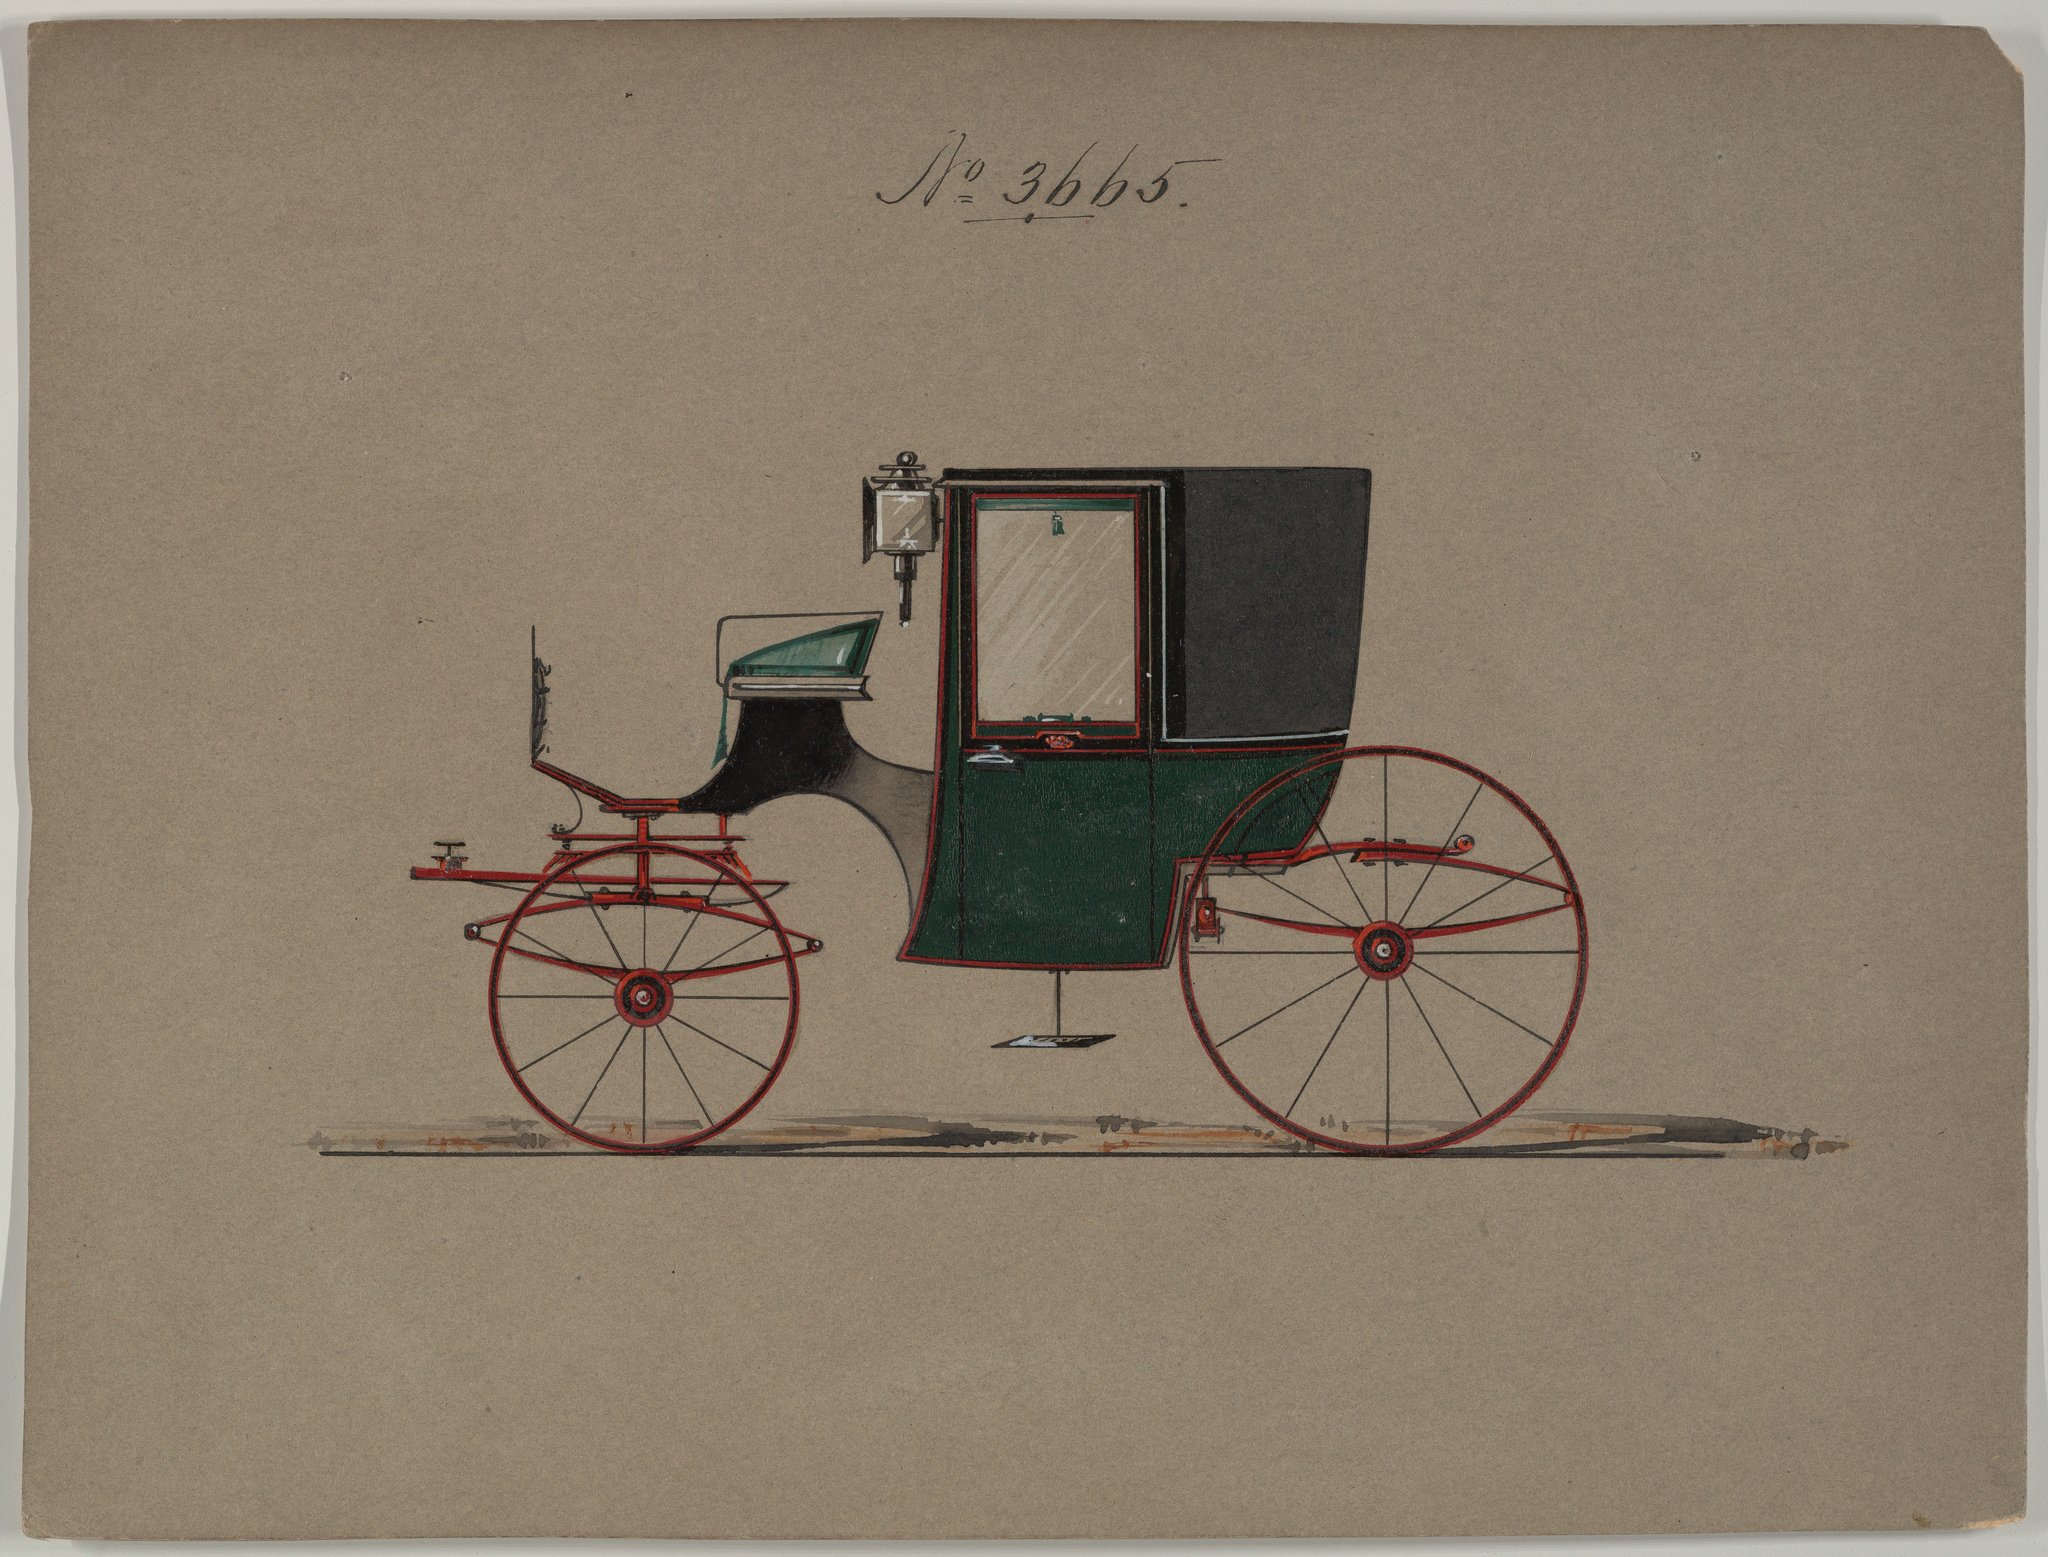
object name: drawing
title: Brougham #3665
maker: brewster & co.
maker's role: manufacturer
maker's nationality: american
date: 1881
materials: gouache, gum arabic, ink, watercolor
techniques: pen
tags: carriages